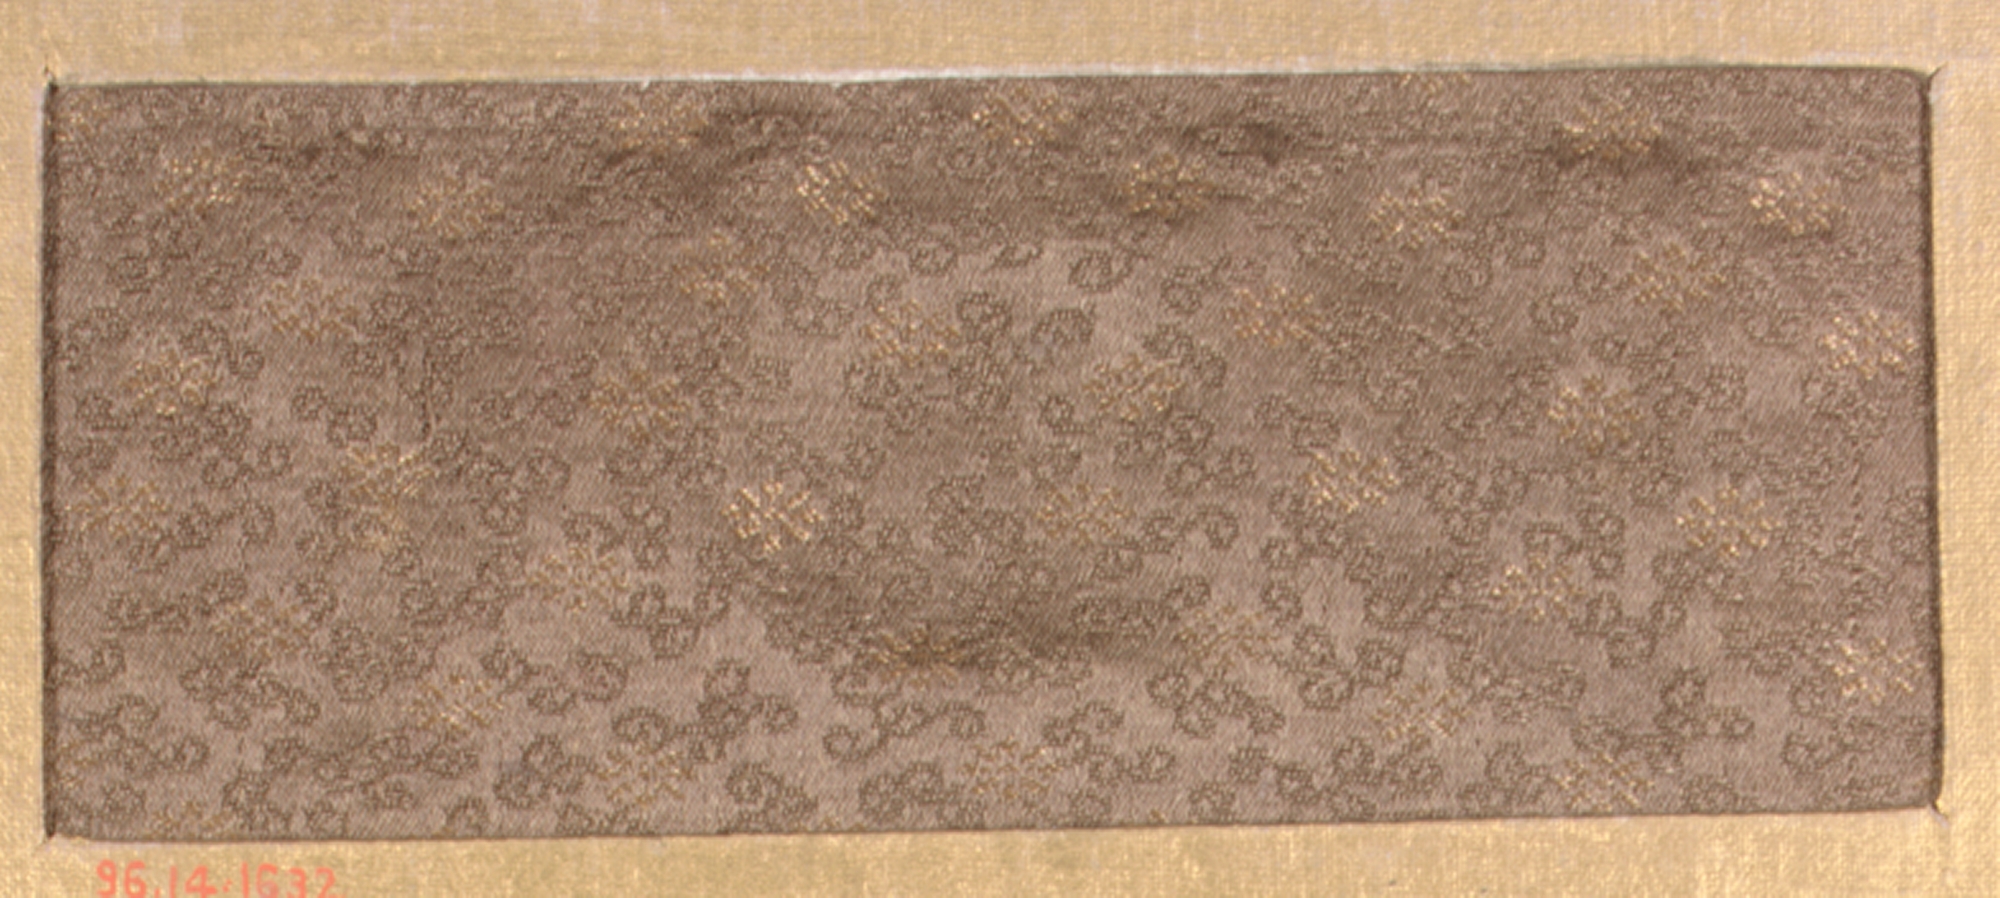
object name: piece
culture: japanese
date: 1701-1900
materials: silk